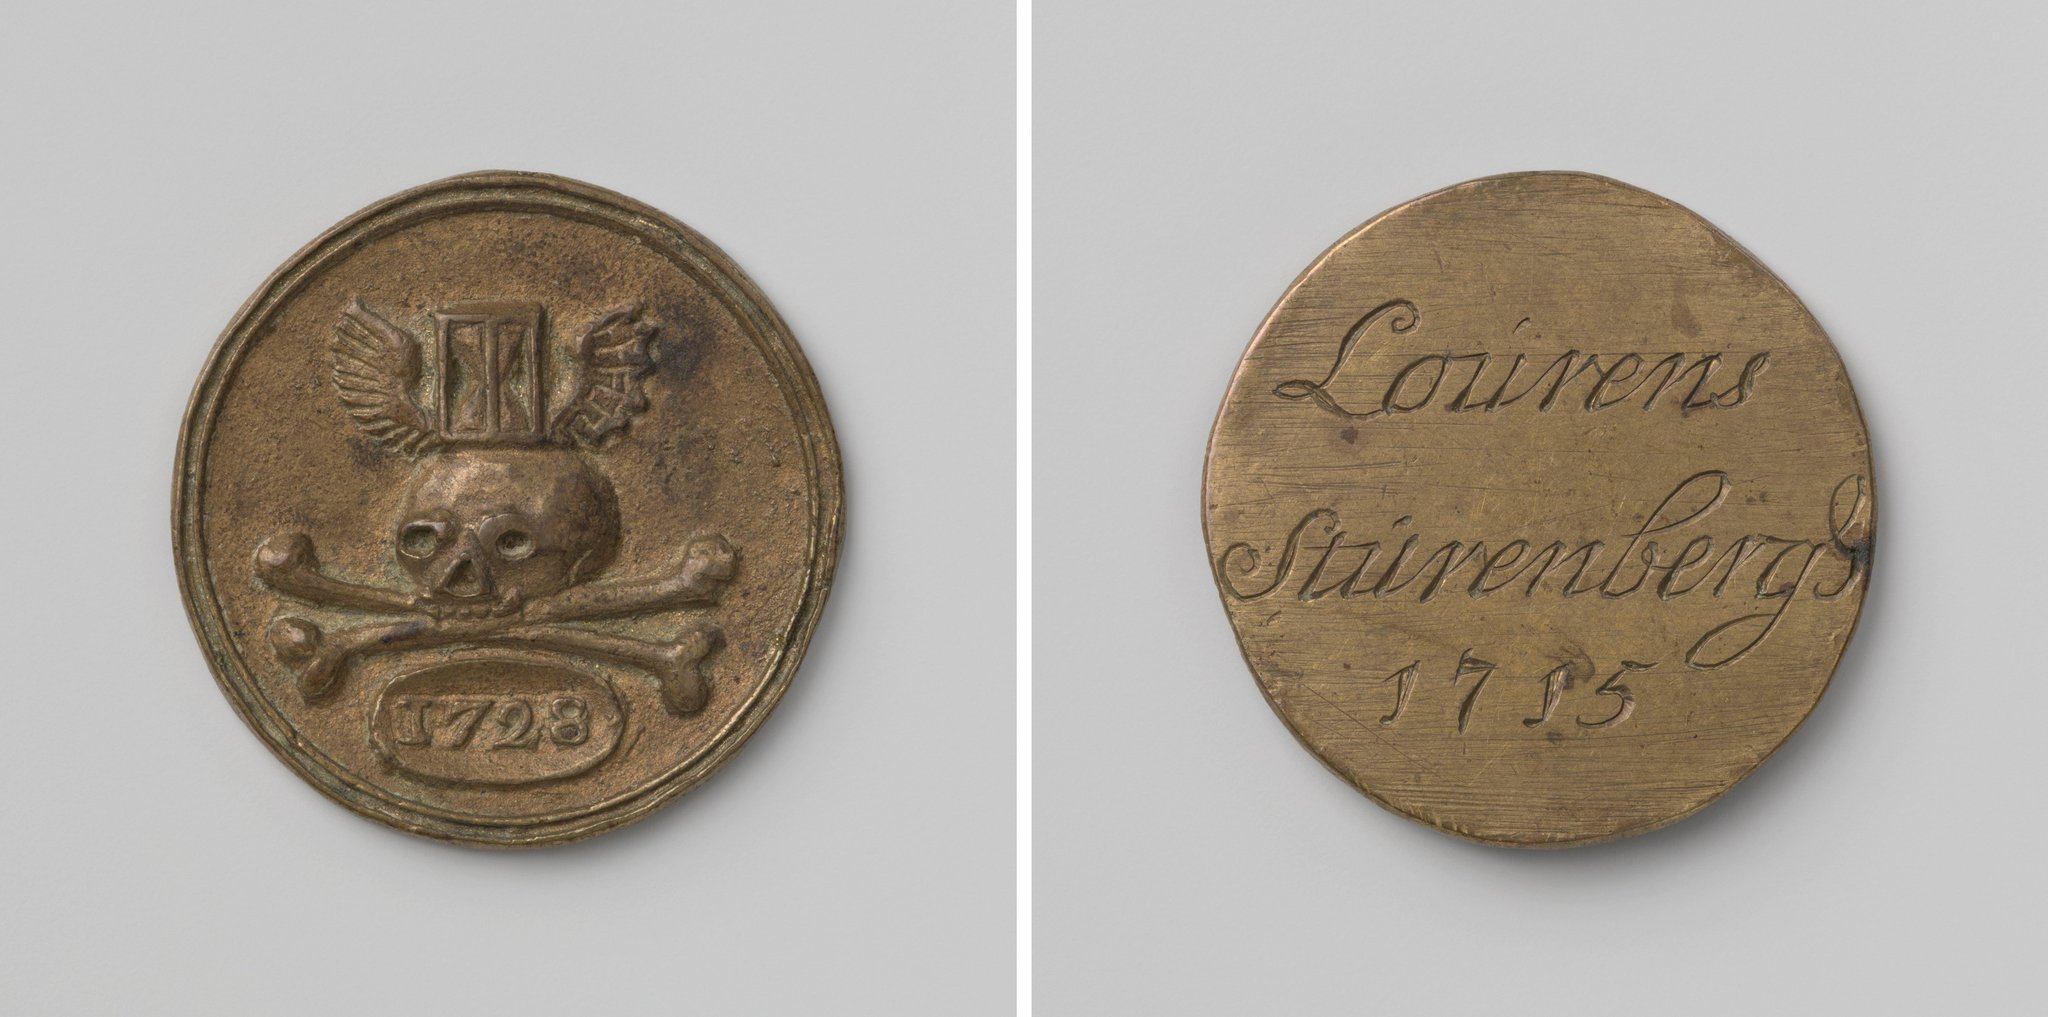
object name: medal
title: Kuipersgilde van Amsterdam, begrafenispenning van Lourens Sturenbergs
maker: Anonymous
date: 1728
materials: brass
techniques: casting, engraving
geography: amsterdam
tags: amsterdam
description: Messing penning. Voorzijde: gevleugelde zandloper boven doodshoofd, twee gekruiste beenderen en jaartal in compartiment. Keerzijde: opschrift boven jaartal